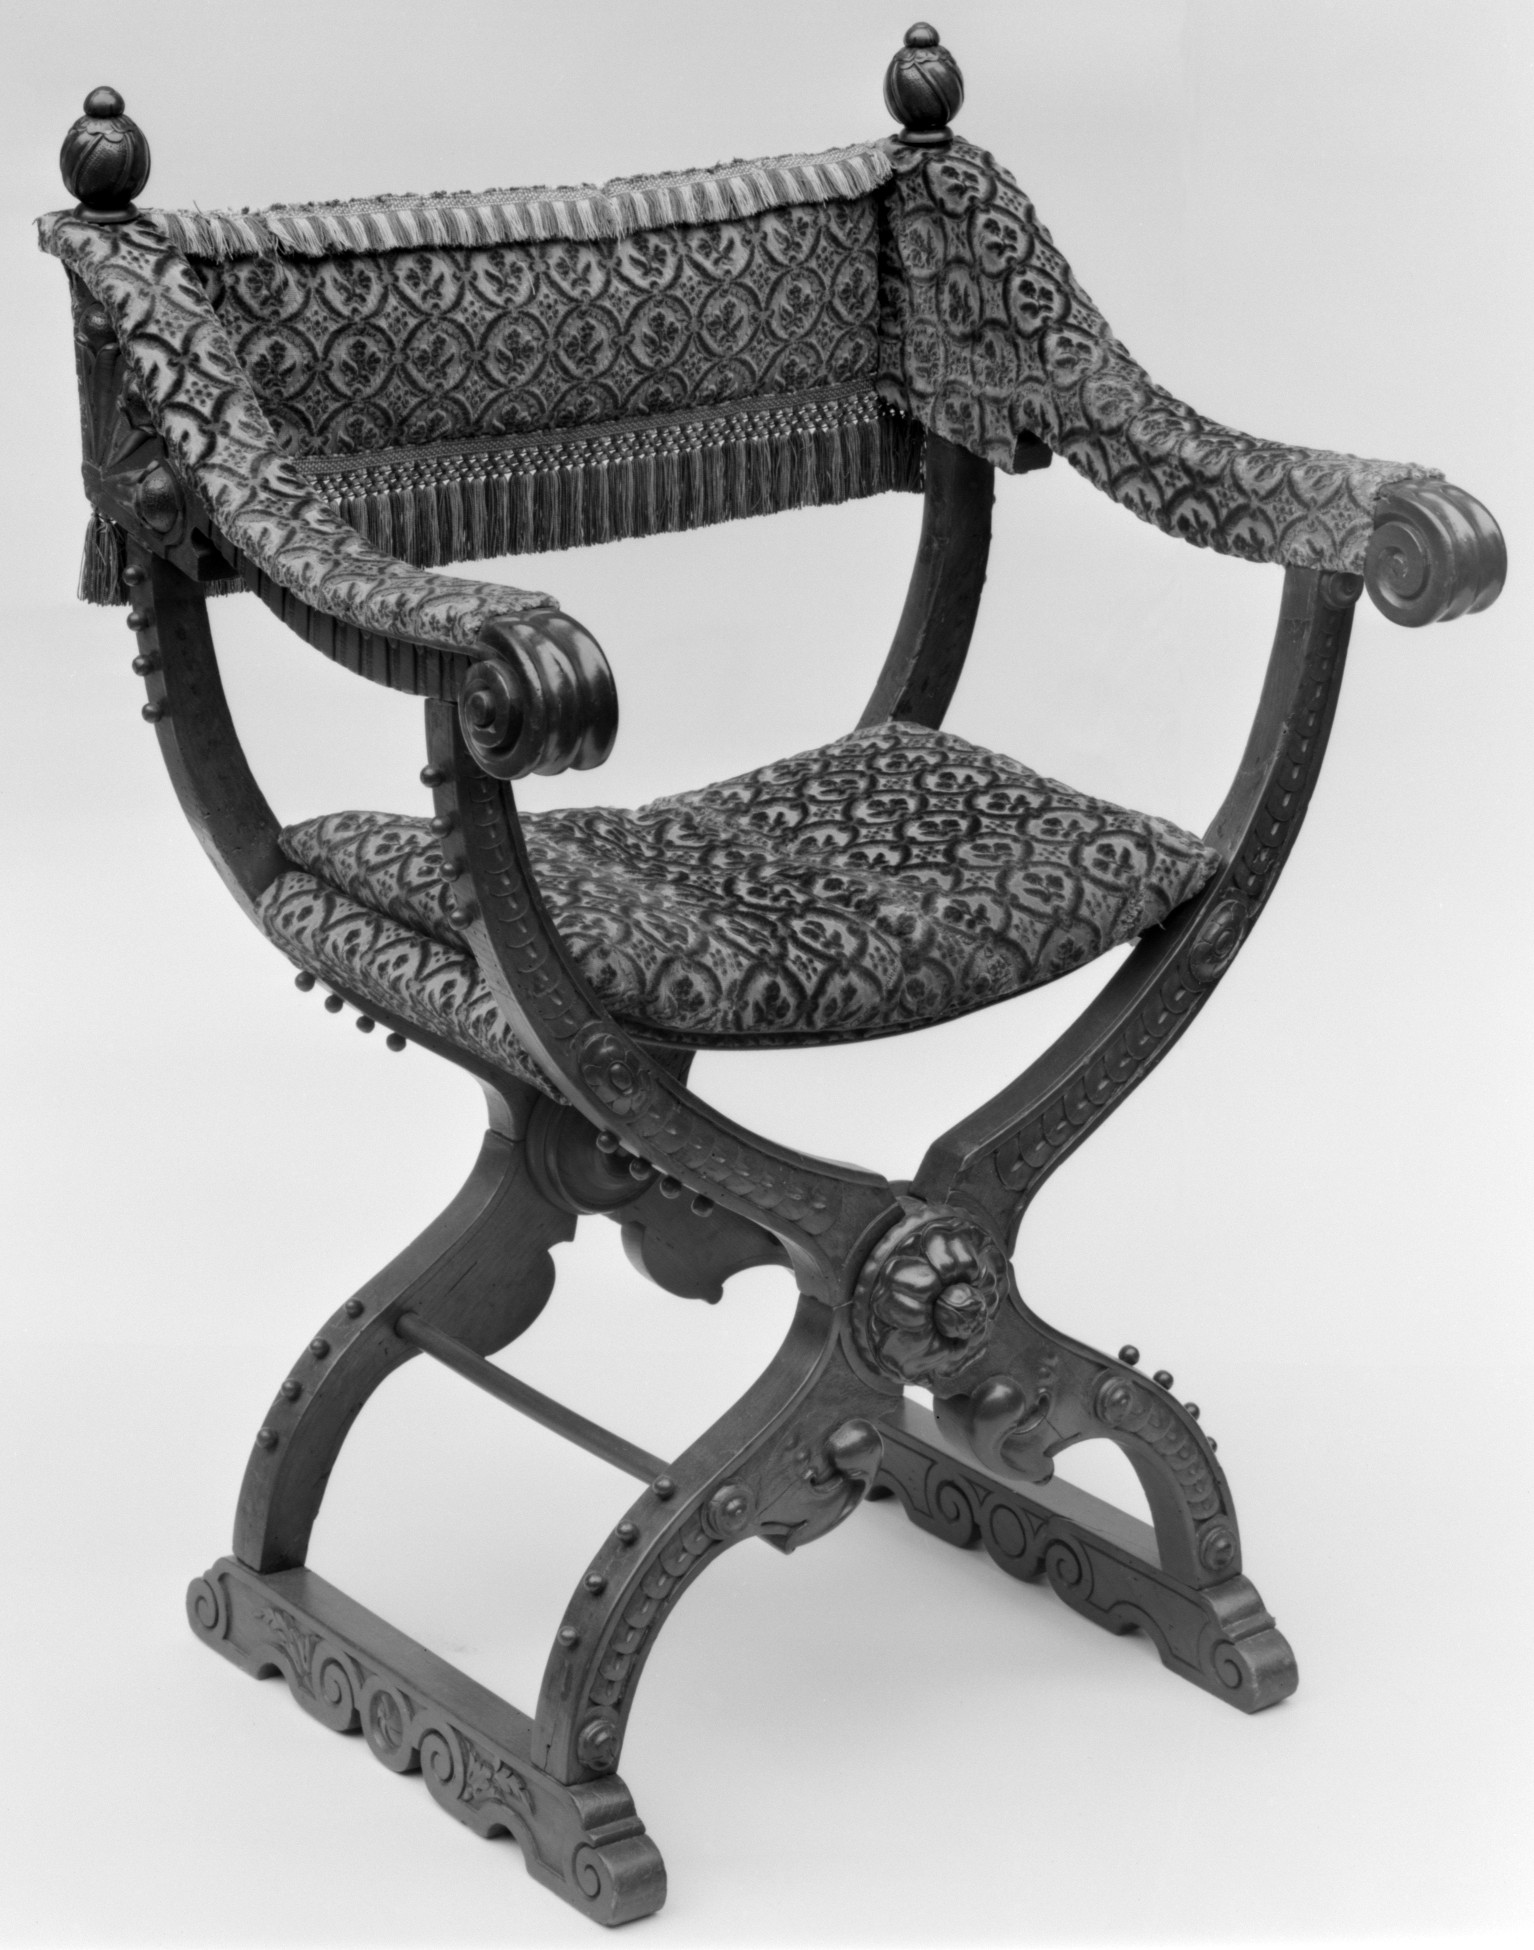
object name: armchair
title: Folding armchair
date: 1801-1900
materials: wood